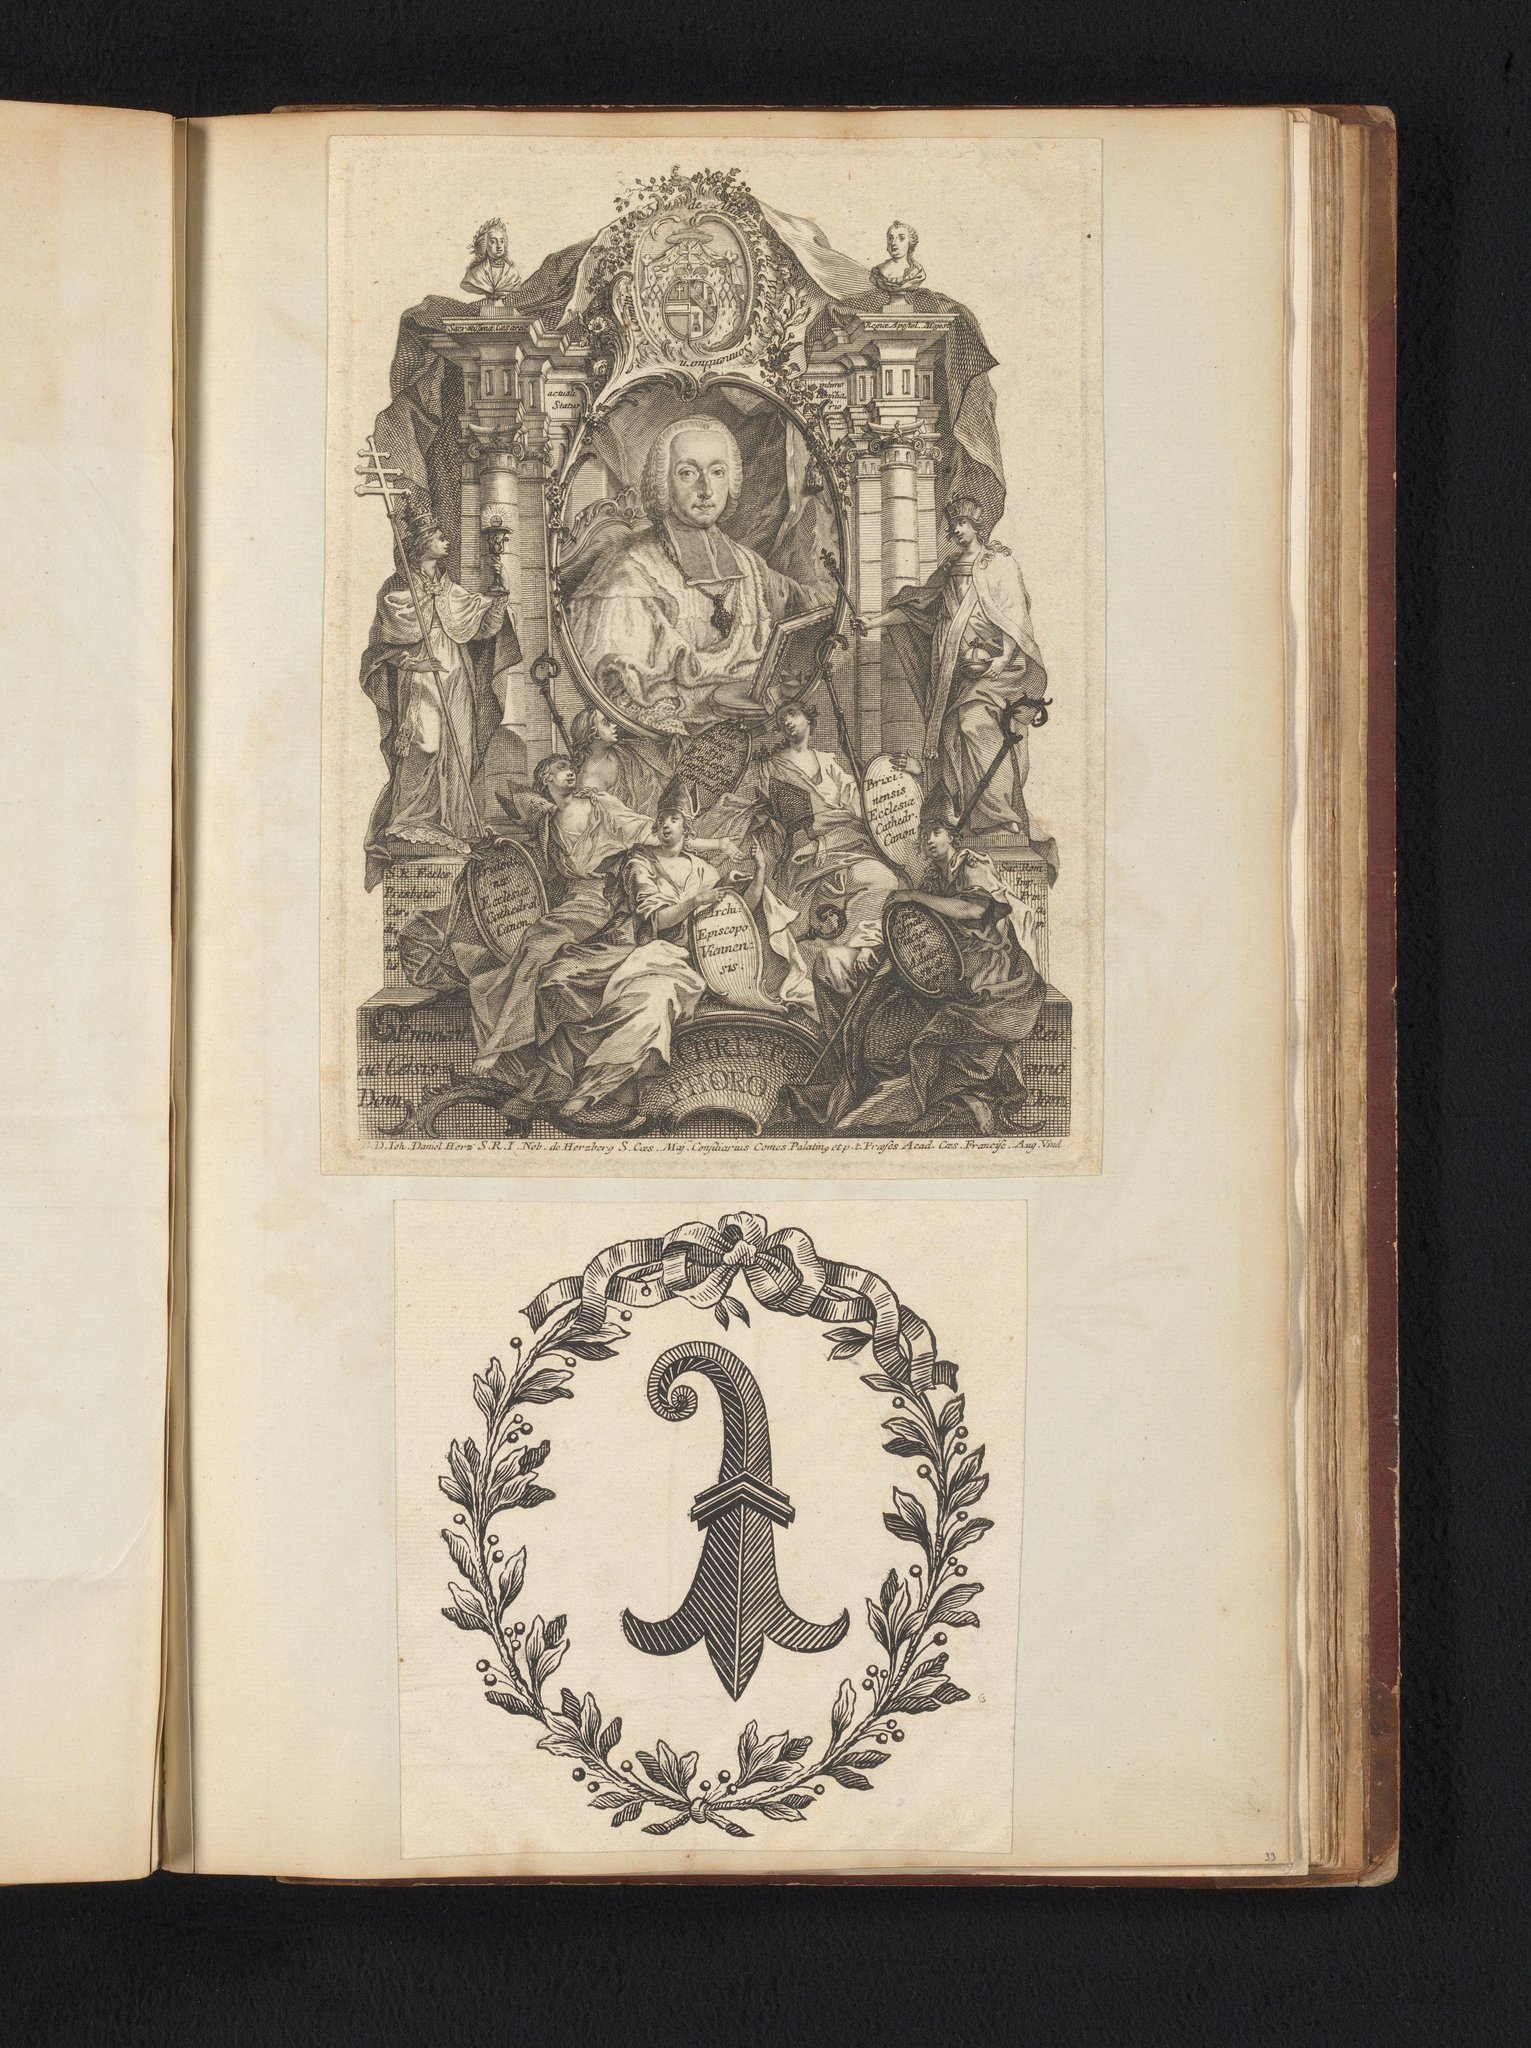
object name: album leaf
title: Portret en wapen van Bazel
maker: johann daniel herz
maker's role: print maker, publisher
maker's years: 1720-1793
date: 1750-1816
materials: paper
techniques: engraving, etching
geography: augsburg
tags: historical persons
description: Portret van een vorst en een bisschoppelijke kromstaf binnen lauwerkrans, het wapen van Bazel. Onderdeel van het tweede van twee albums met ingeplakte prenten en tekeningen te dienen als tekenvoorbeelden.